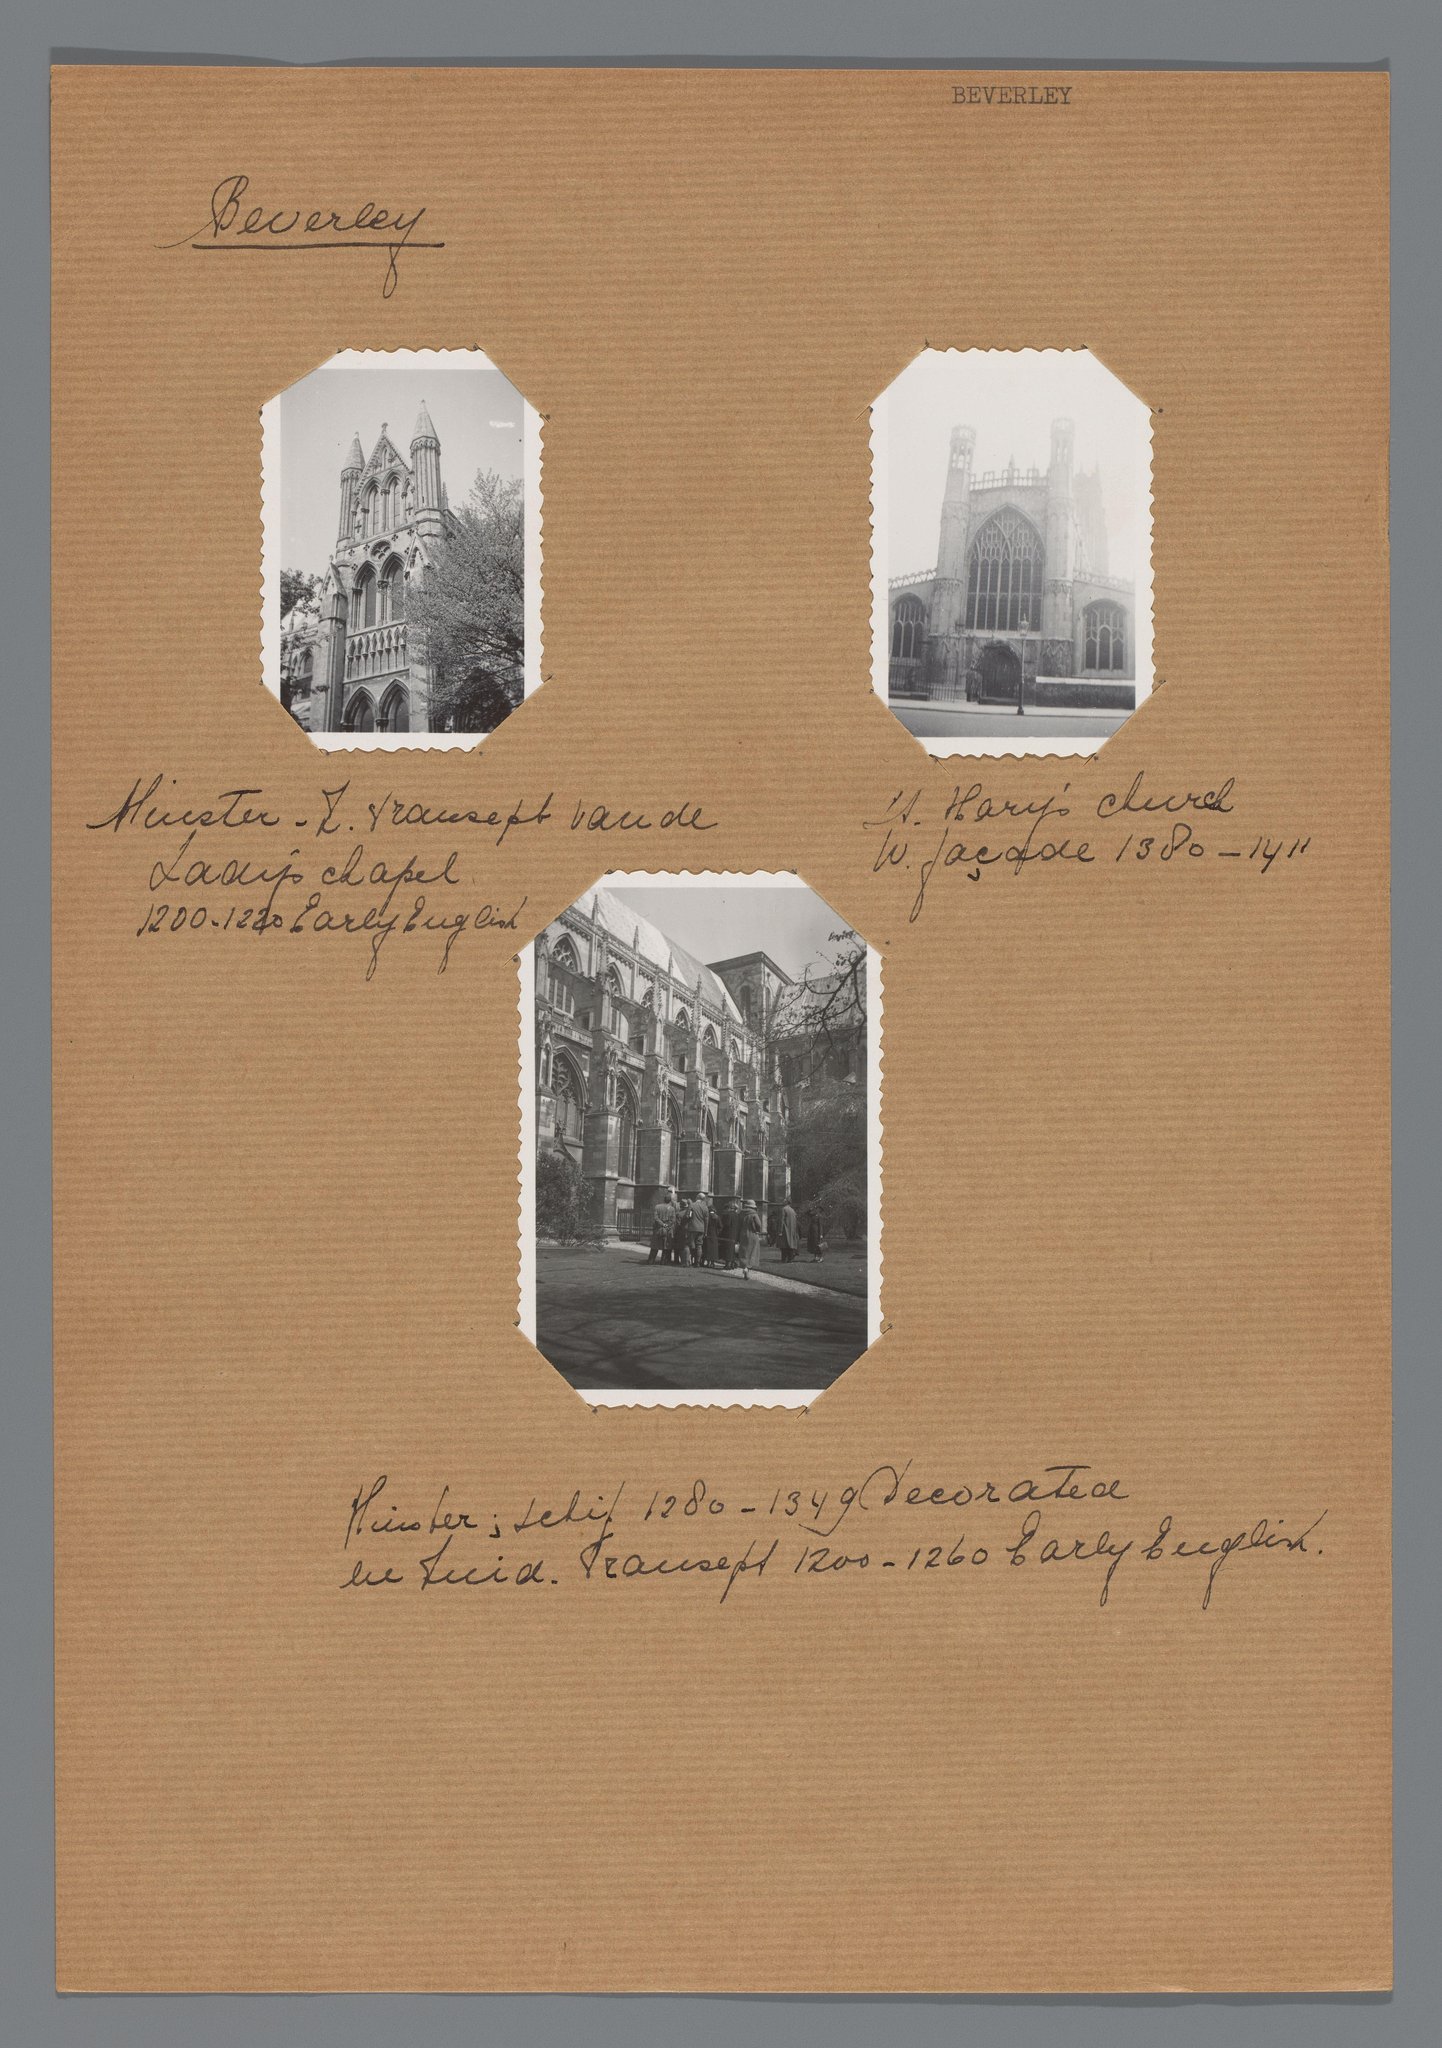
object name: photograph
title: Beverley. England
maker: Anonymous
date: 1880-1920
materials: photographic support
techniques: gelatin silver print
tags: beverley